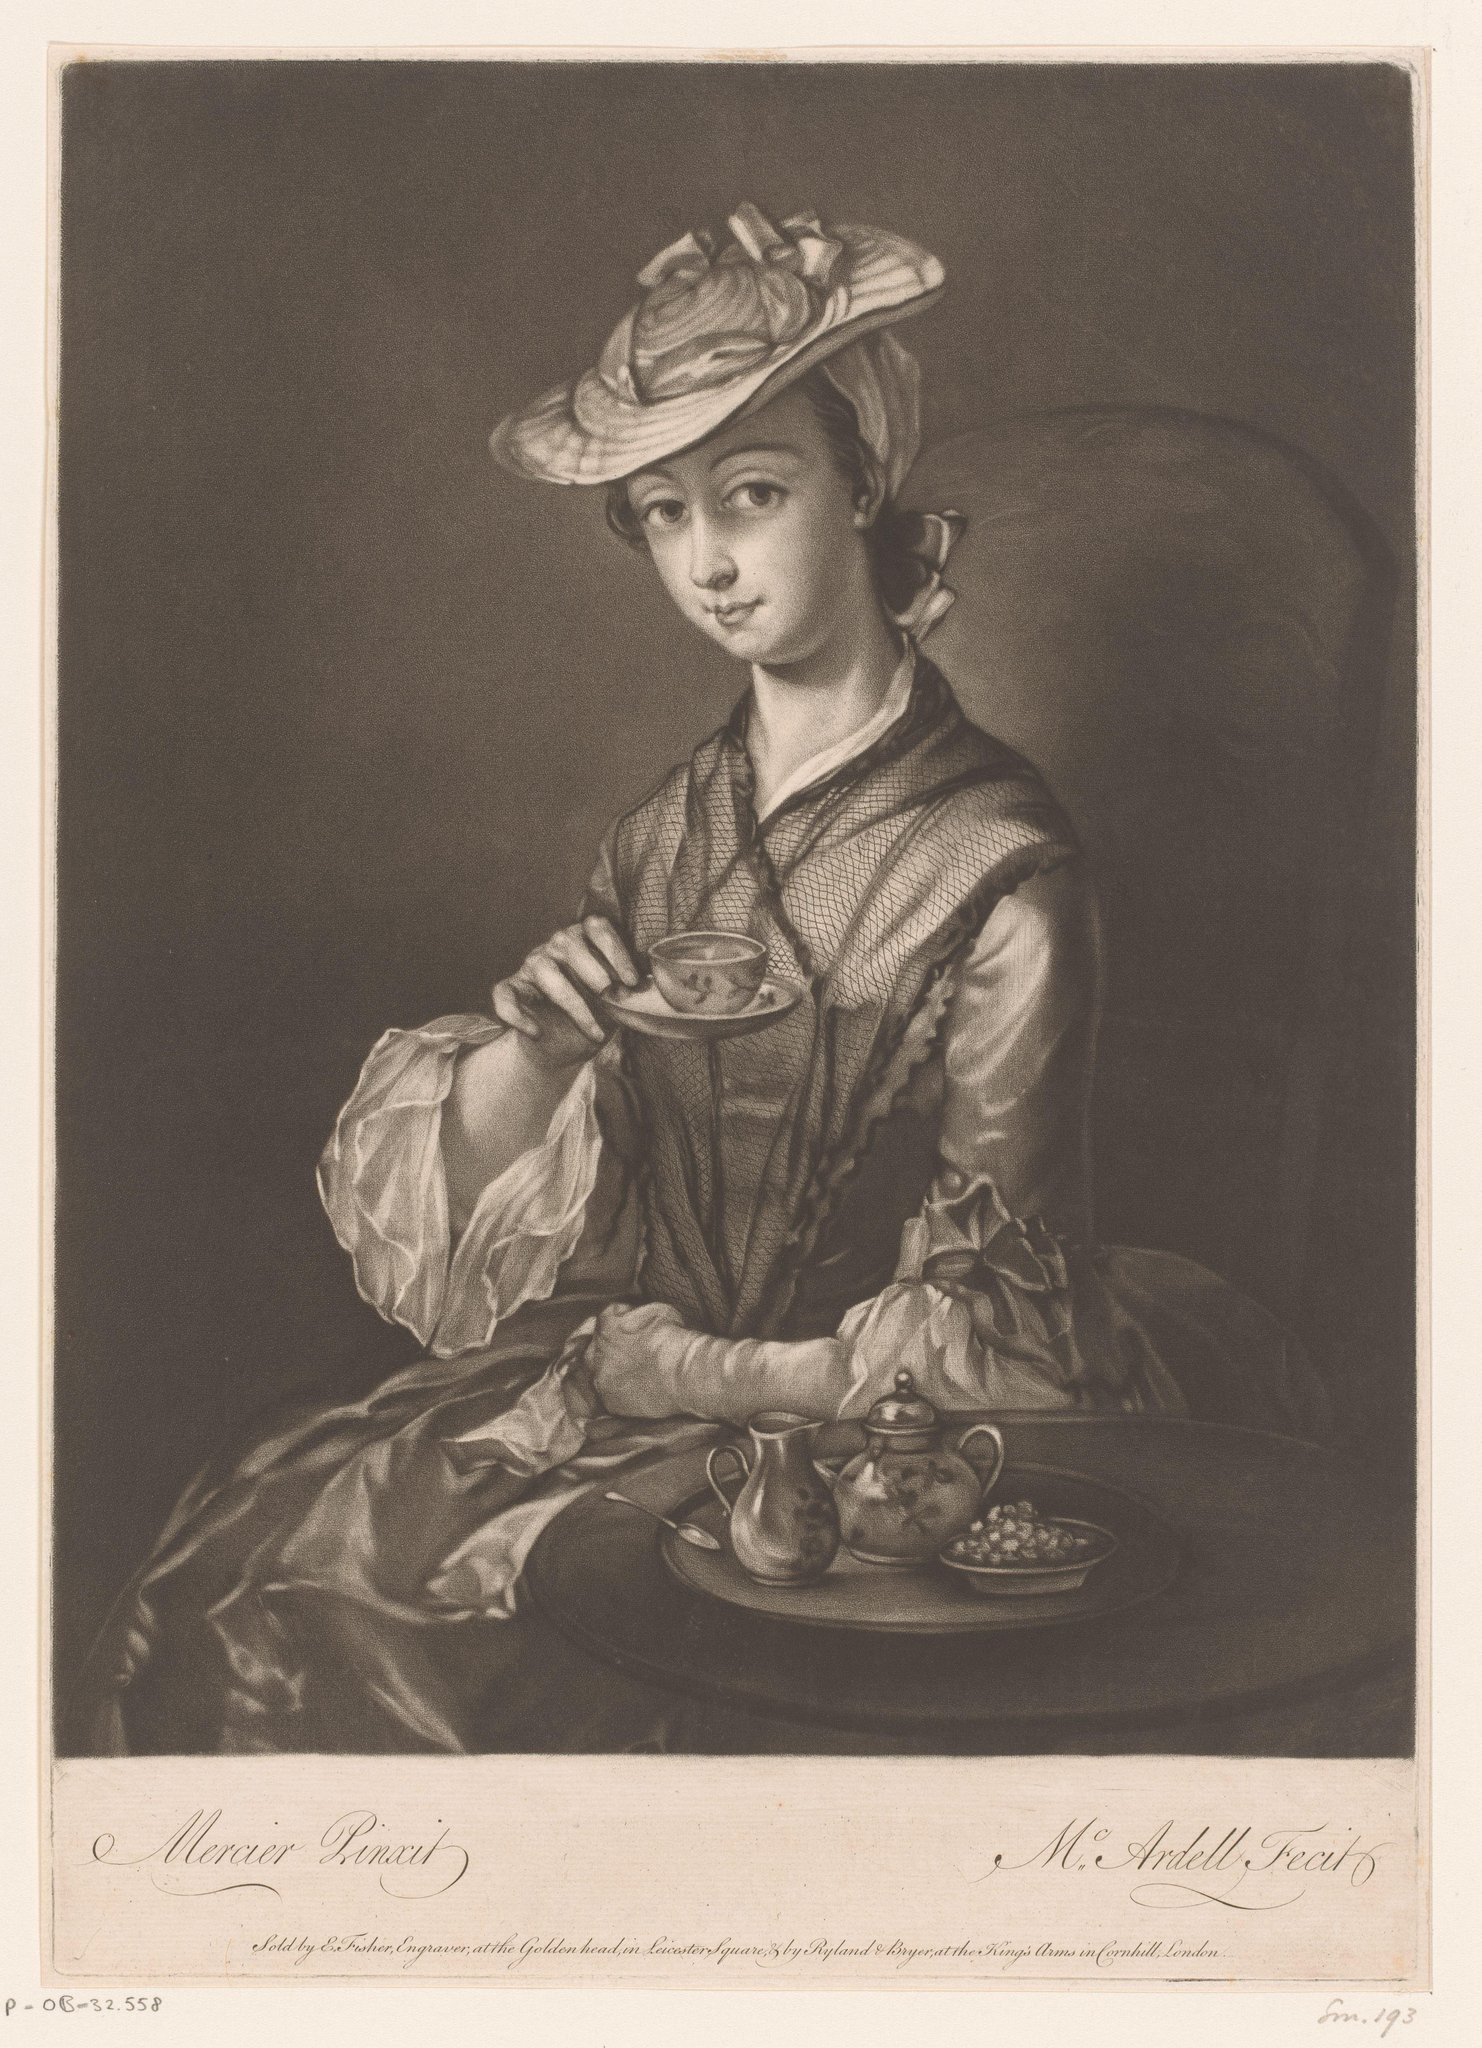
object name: print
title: Portret van een onbekende vrouw, theedrinkend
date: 1756-1765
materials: paper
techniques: mezzotint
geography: london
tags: anonymous historical person portrayed alone - bb - woman, tea-pot; samovar, afternoon tea, cup and saucer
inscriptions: collector's mark: Lugt 240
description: Goodwin en Chaloner Smith vermelden dat dit mogelijk een portret is van Merciers dochter.